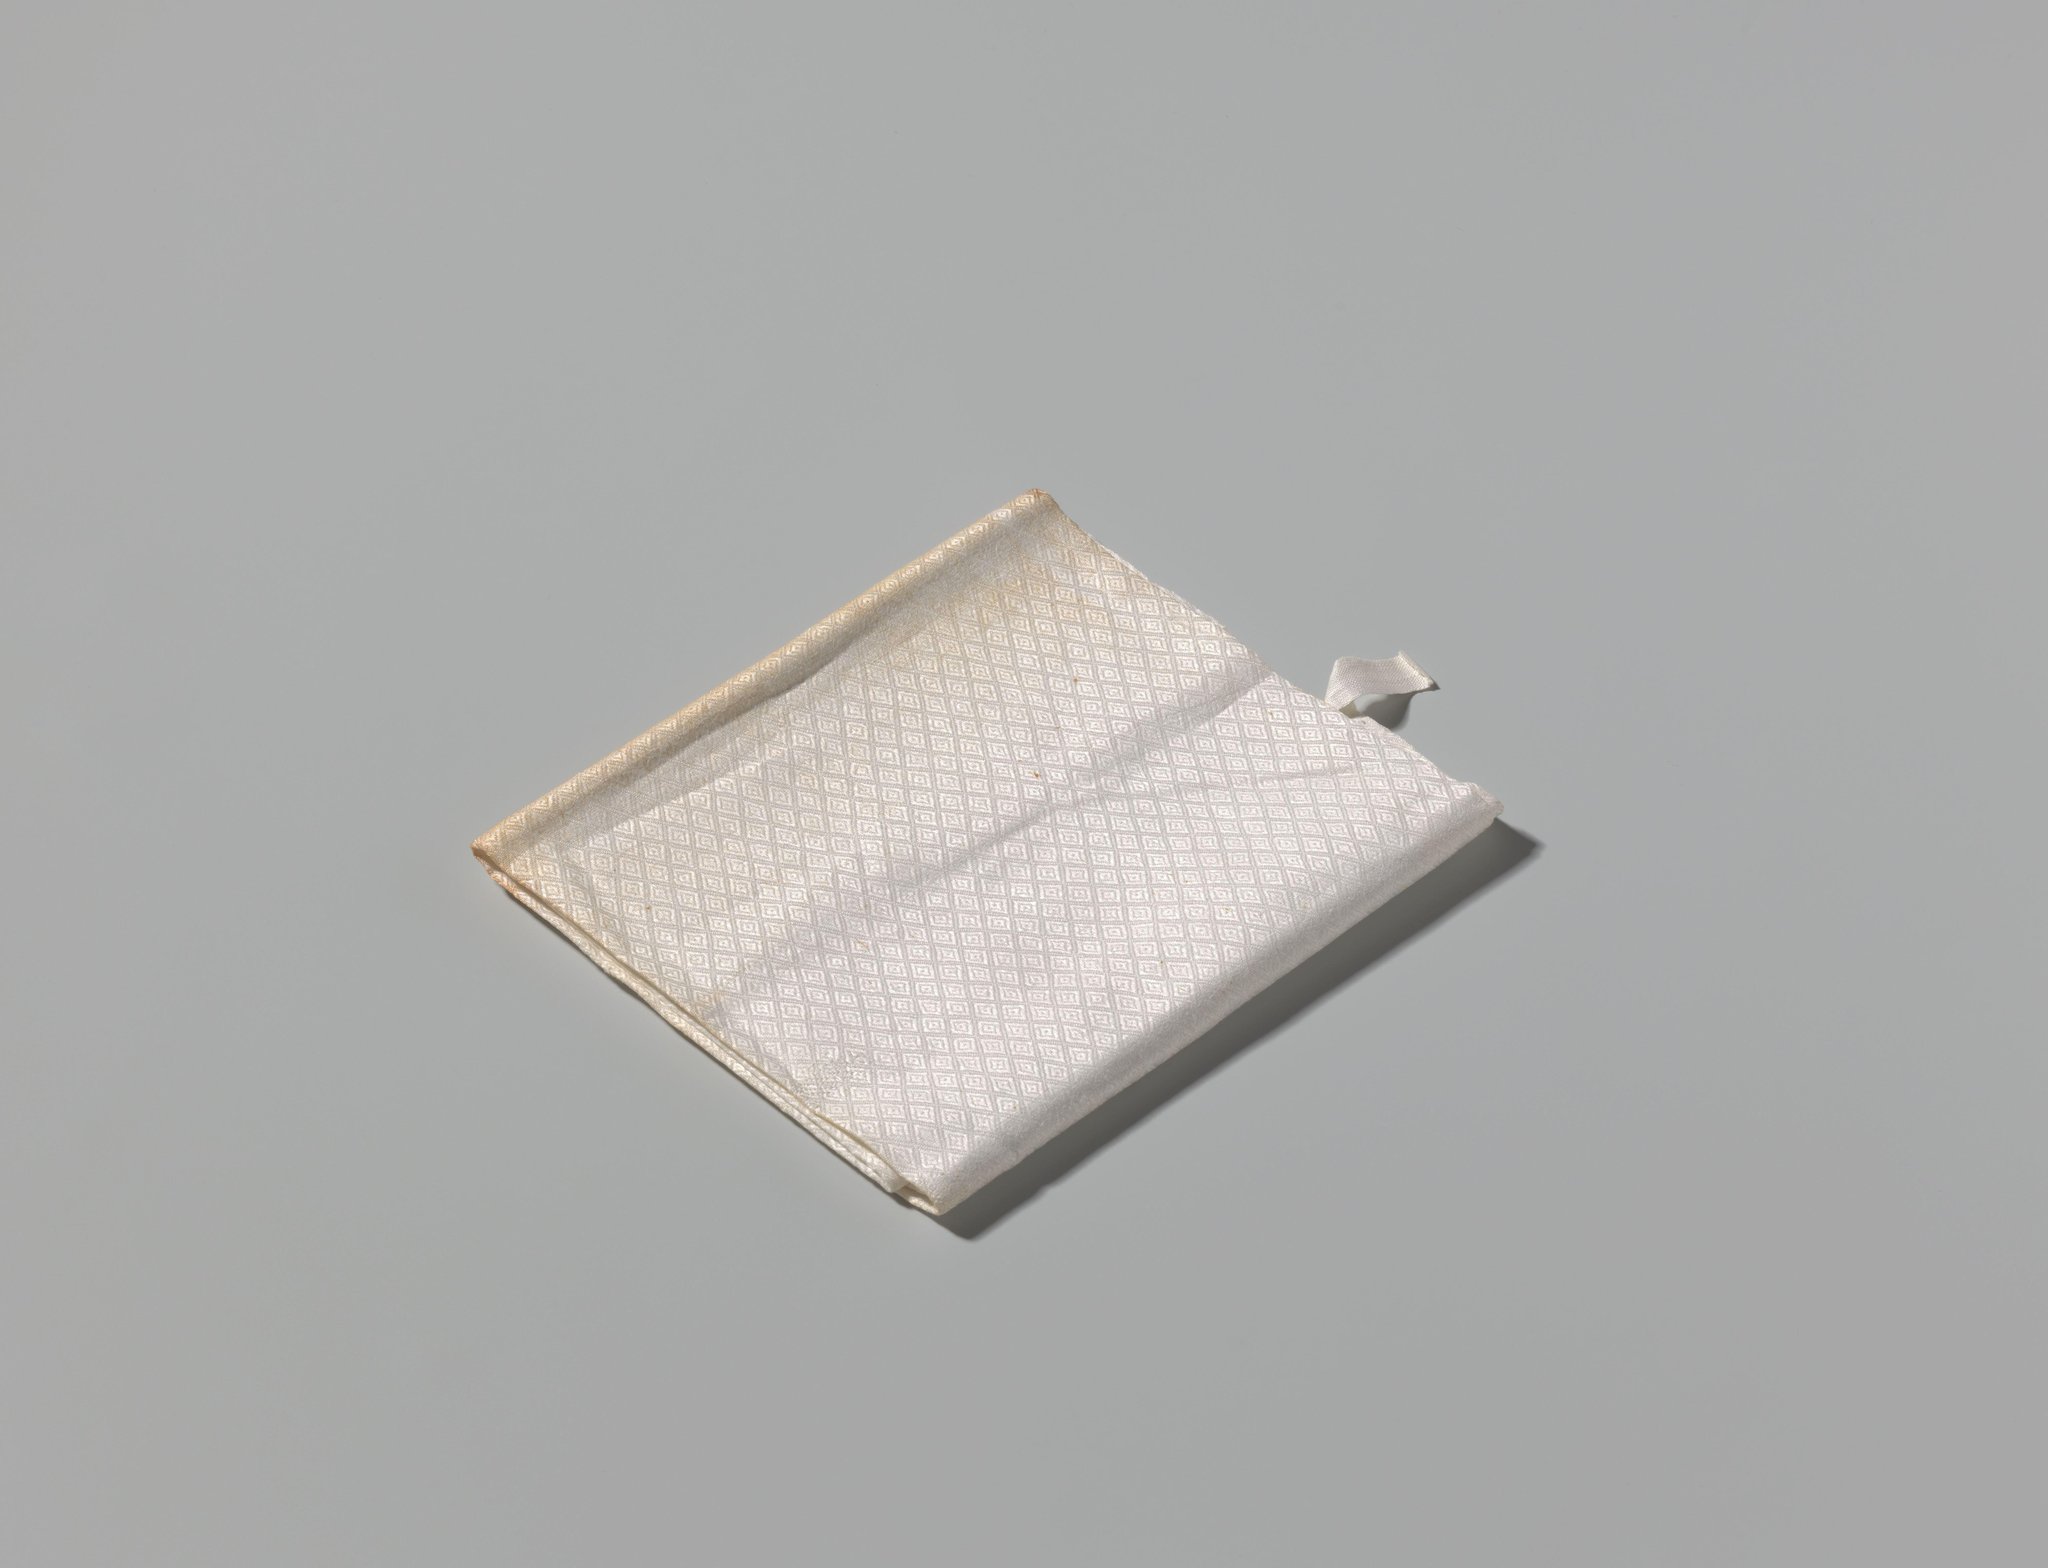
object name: towel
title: Handdoek van wit linnen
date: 1800-1899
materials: linen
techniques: peeled fabric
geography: netherlands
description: Wit linnen handdoek met een pellen patroon z.g. 'gansoog' en randen rondom, merk HK WH 2oonl.